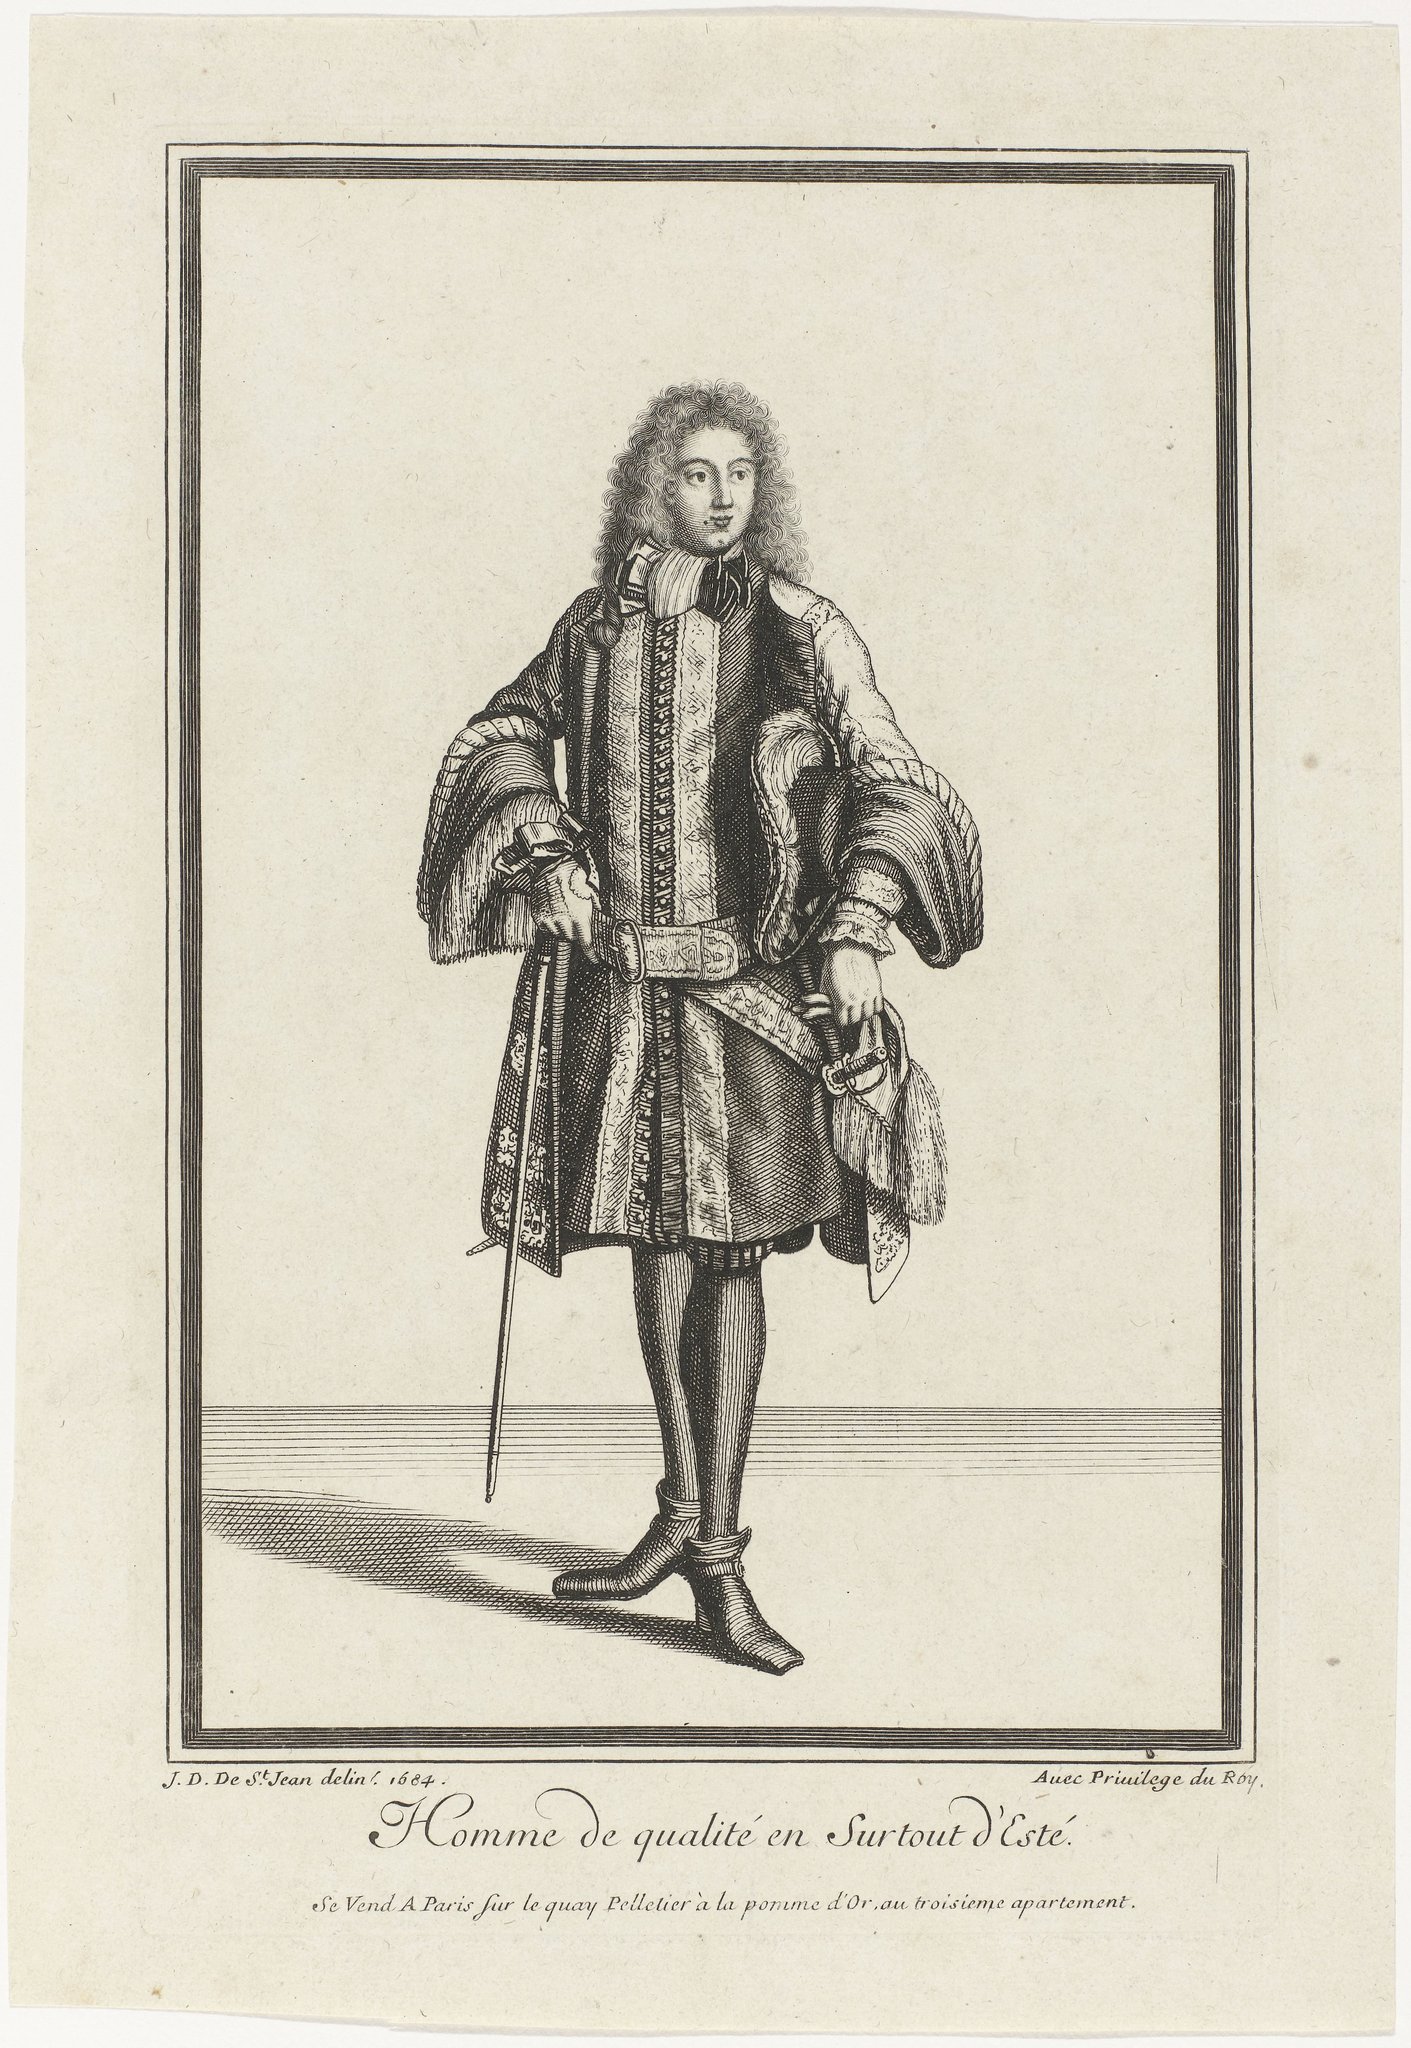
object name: costume print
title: Homme de qualité en Surtout d'Esté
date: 1684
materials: paper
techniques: engraving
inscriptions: date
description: Staande edelman, van voren gezien, cravate boven korte mantel met wijde mouwen en ceintuur. Hoed onder de linkerarm. Schoenen met hak